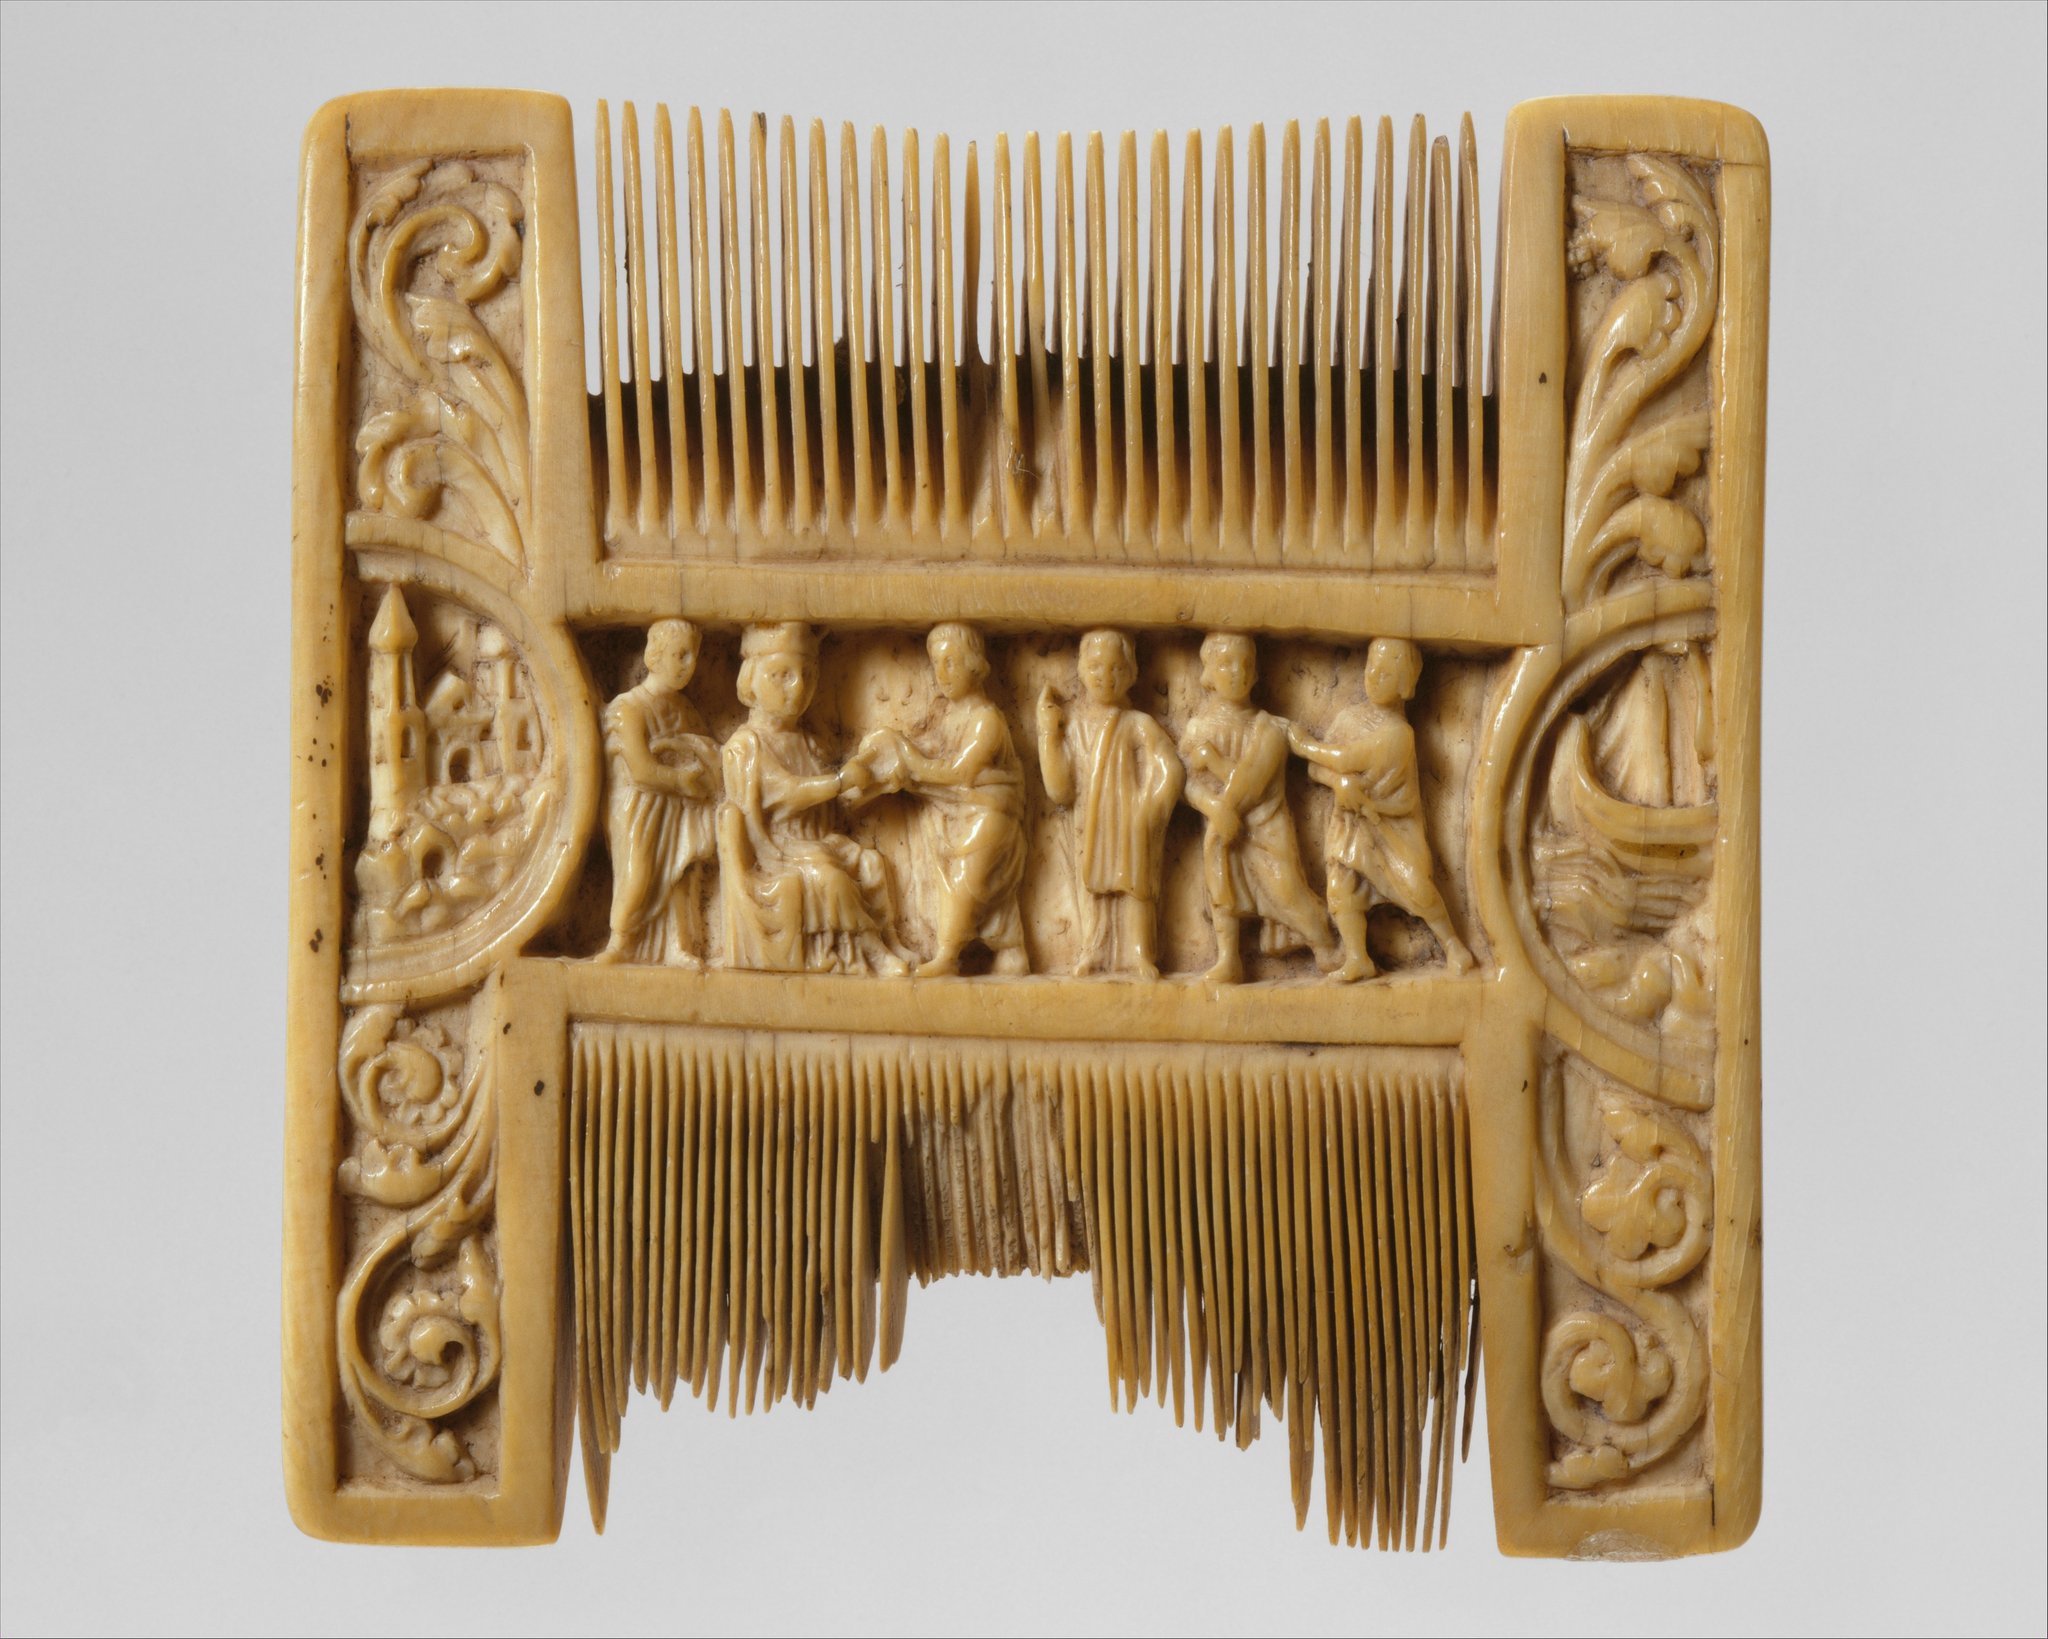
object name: comb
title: Double-Sided Ivory Liturgical Comb with Scenes of Henry II and Thomas Becket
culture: british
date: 1200-1210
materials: ivory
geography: england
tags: men,saints